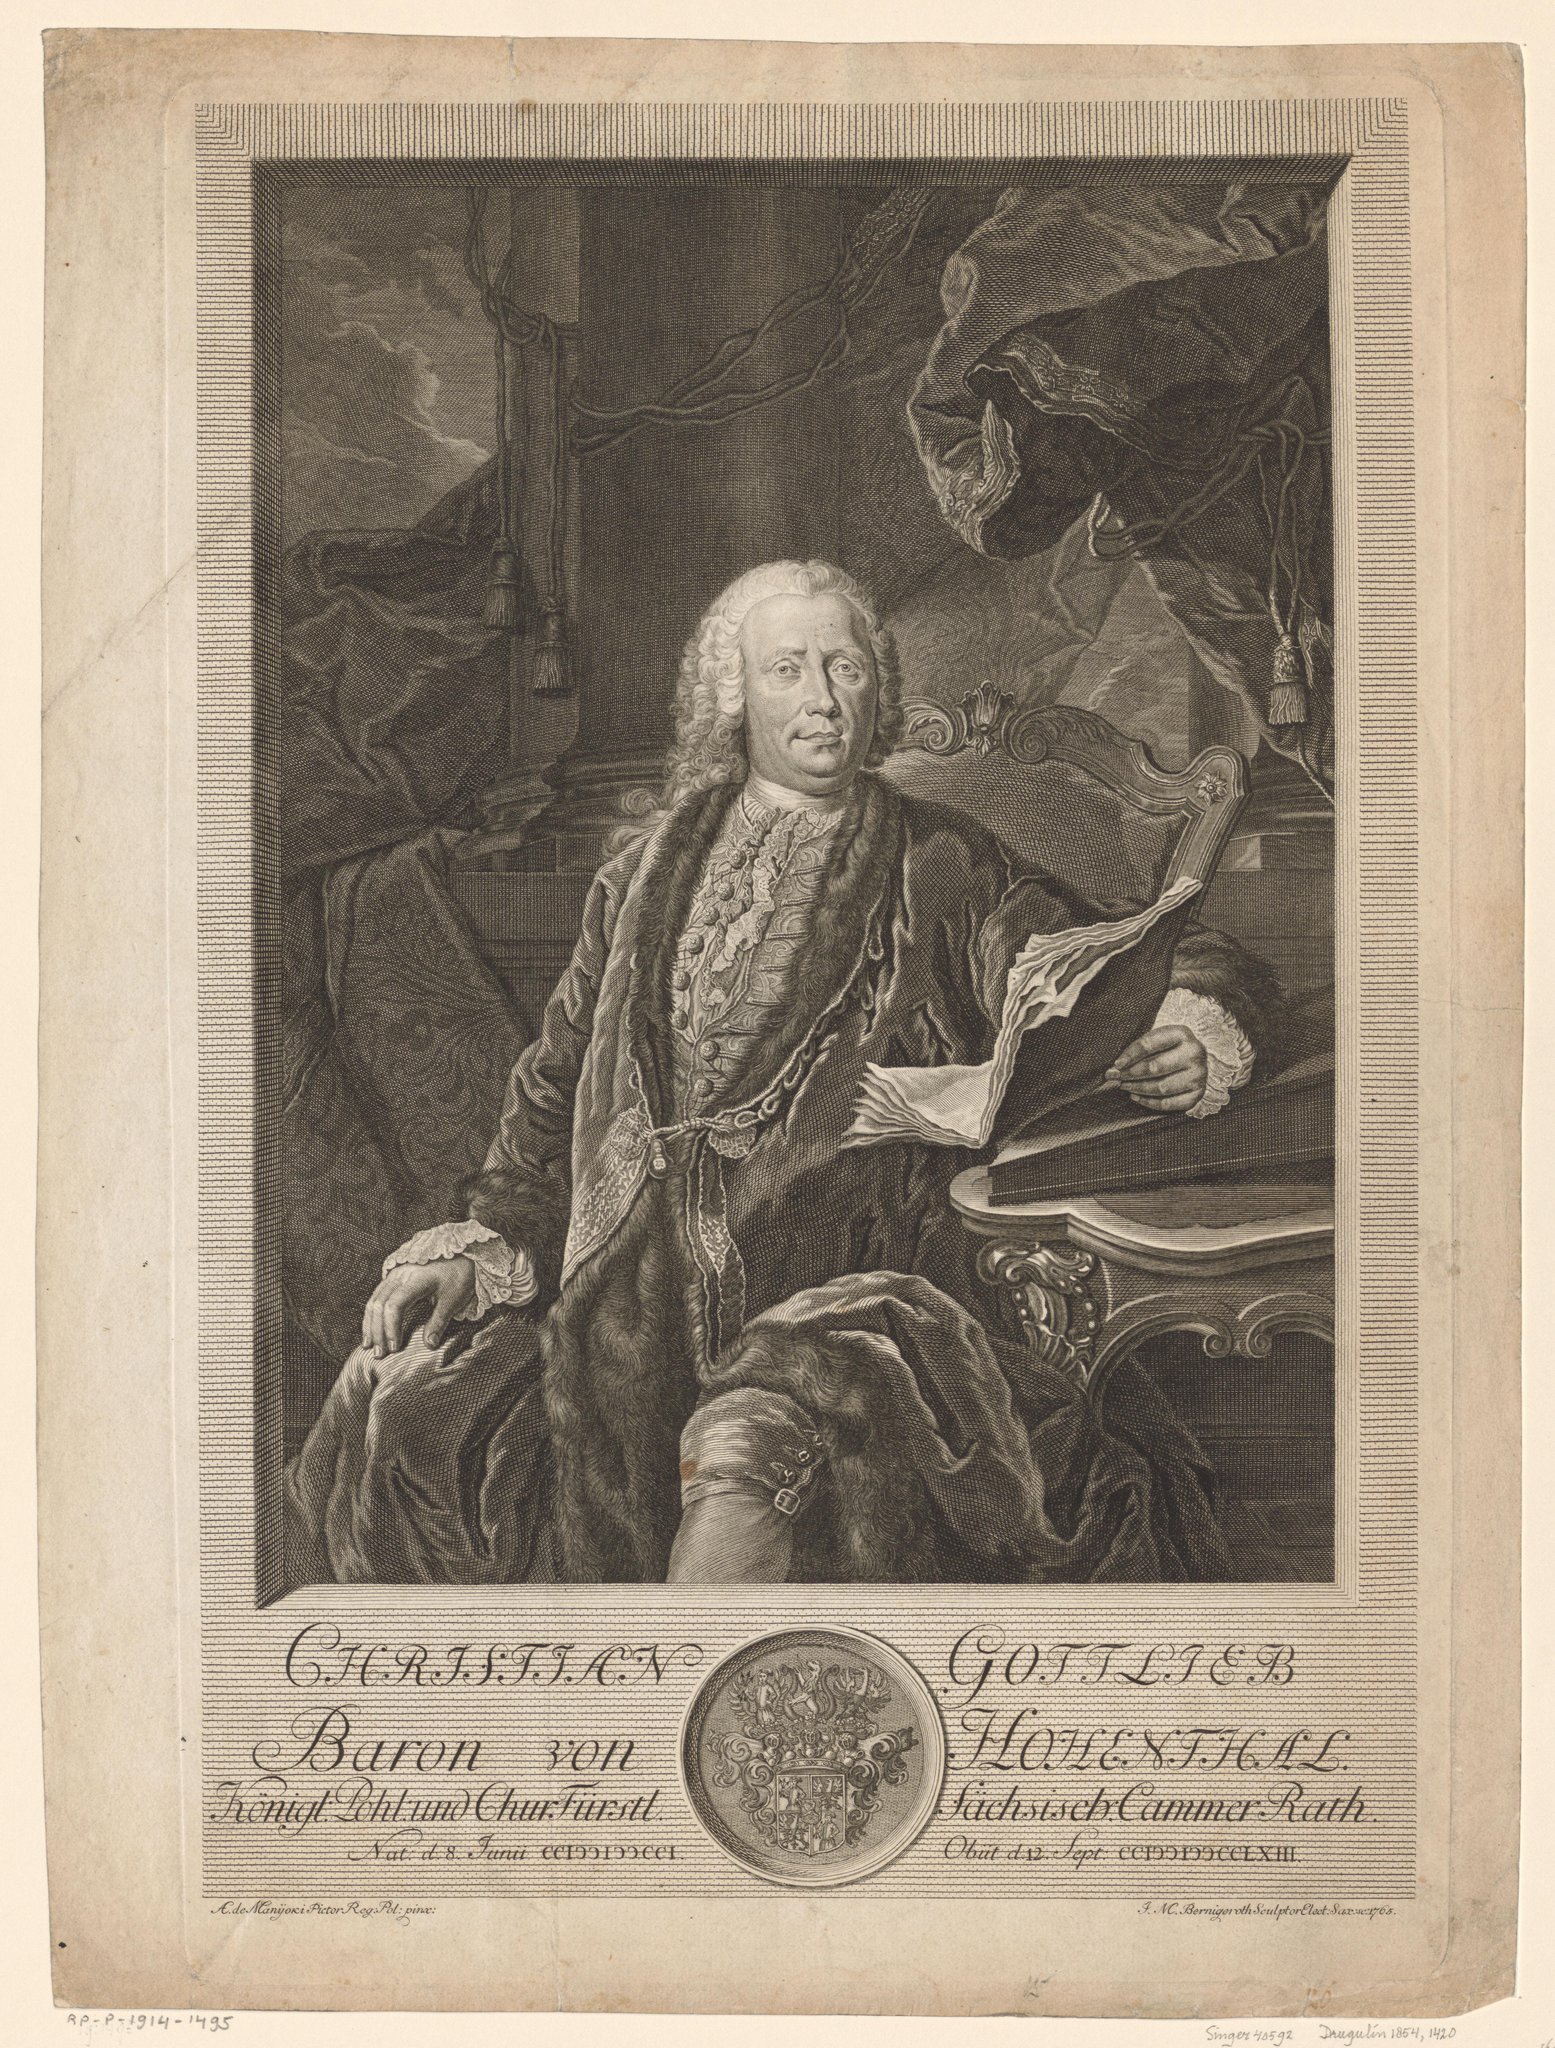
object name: print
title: Portret van Christian Gottlieb Hohmann von Hohenthal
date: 1765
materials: paper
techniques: engraving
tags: historical persons, armorial bearing, heraldry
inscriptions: collector's mark: Lugt 2228